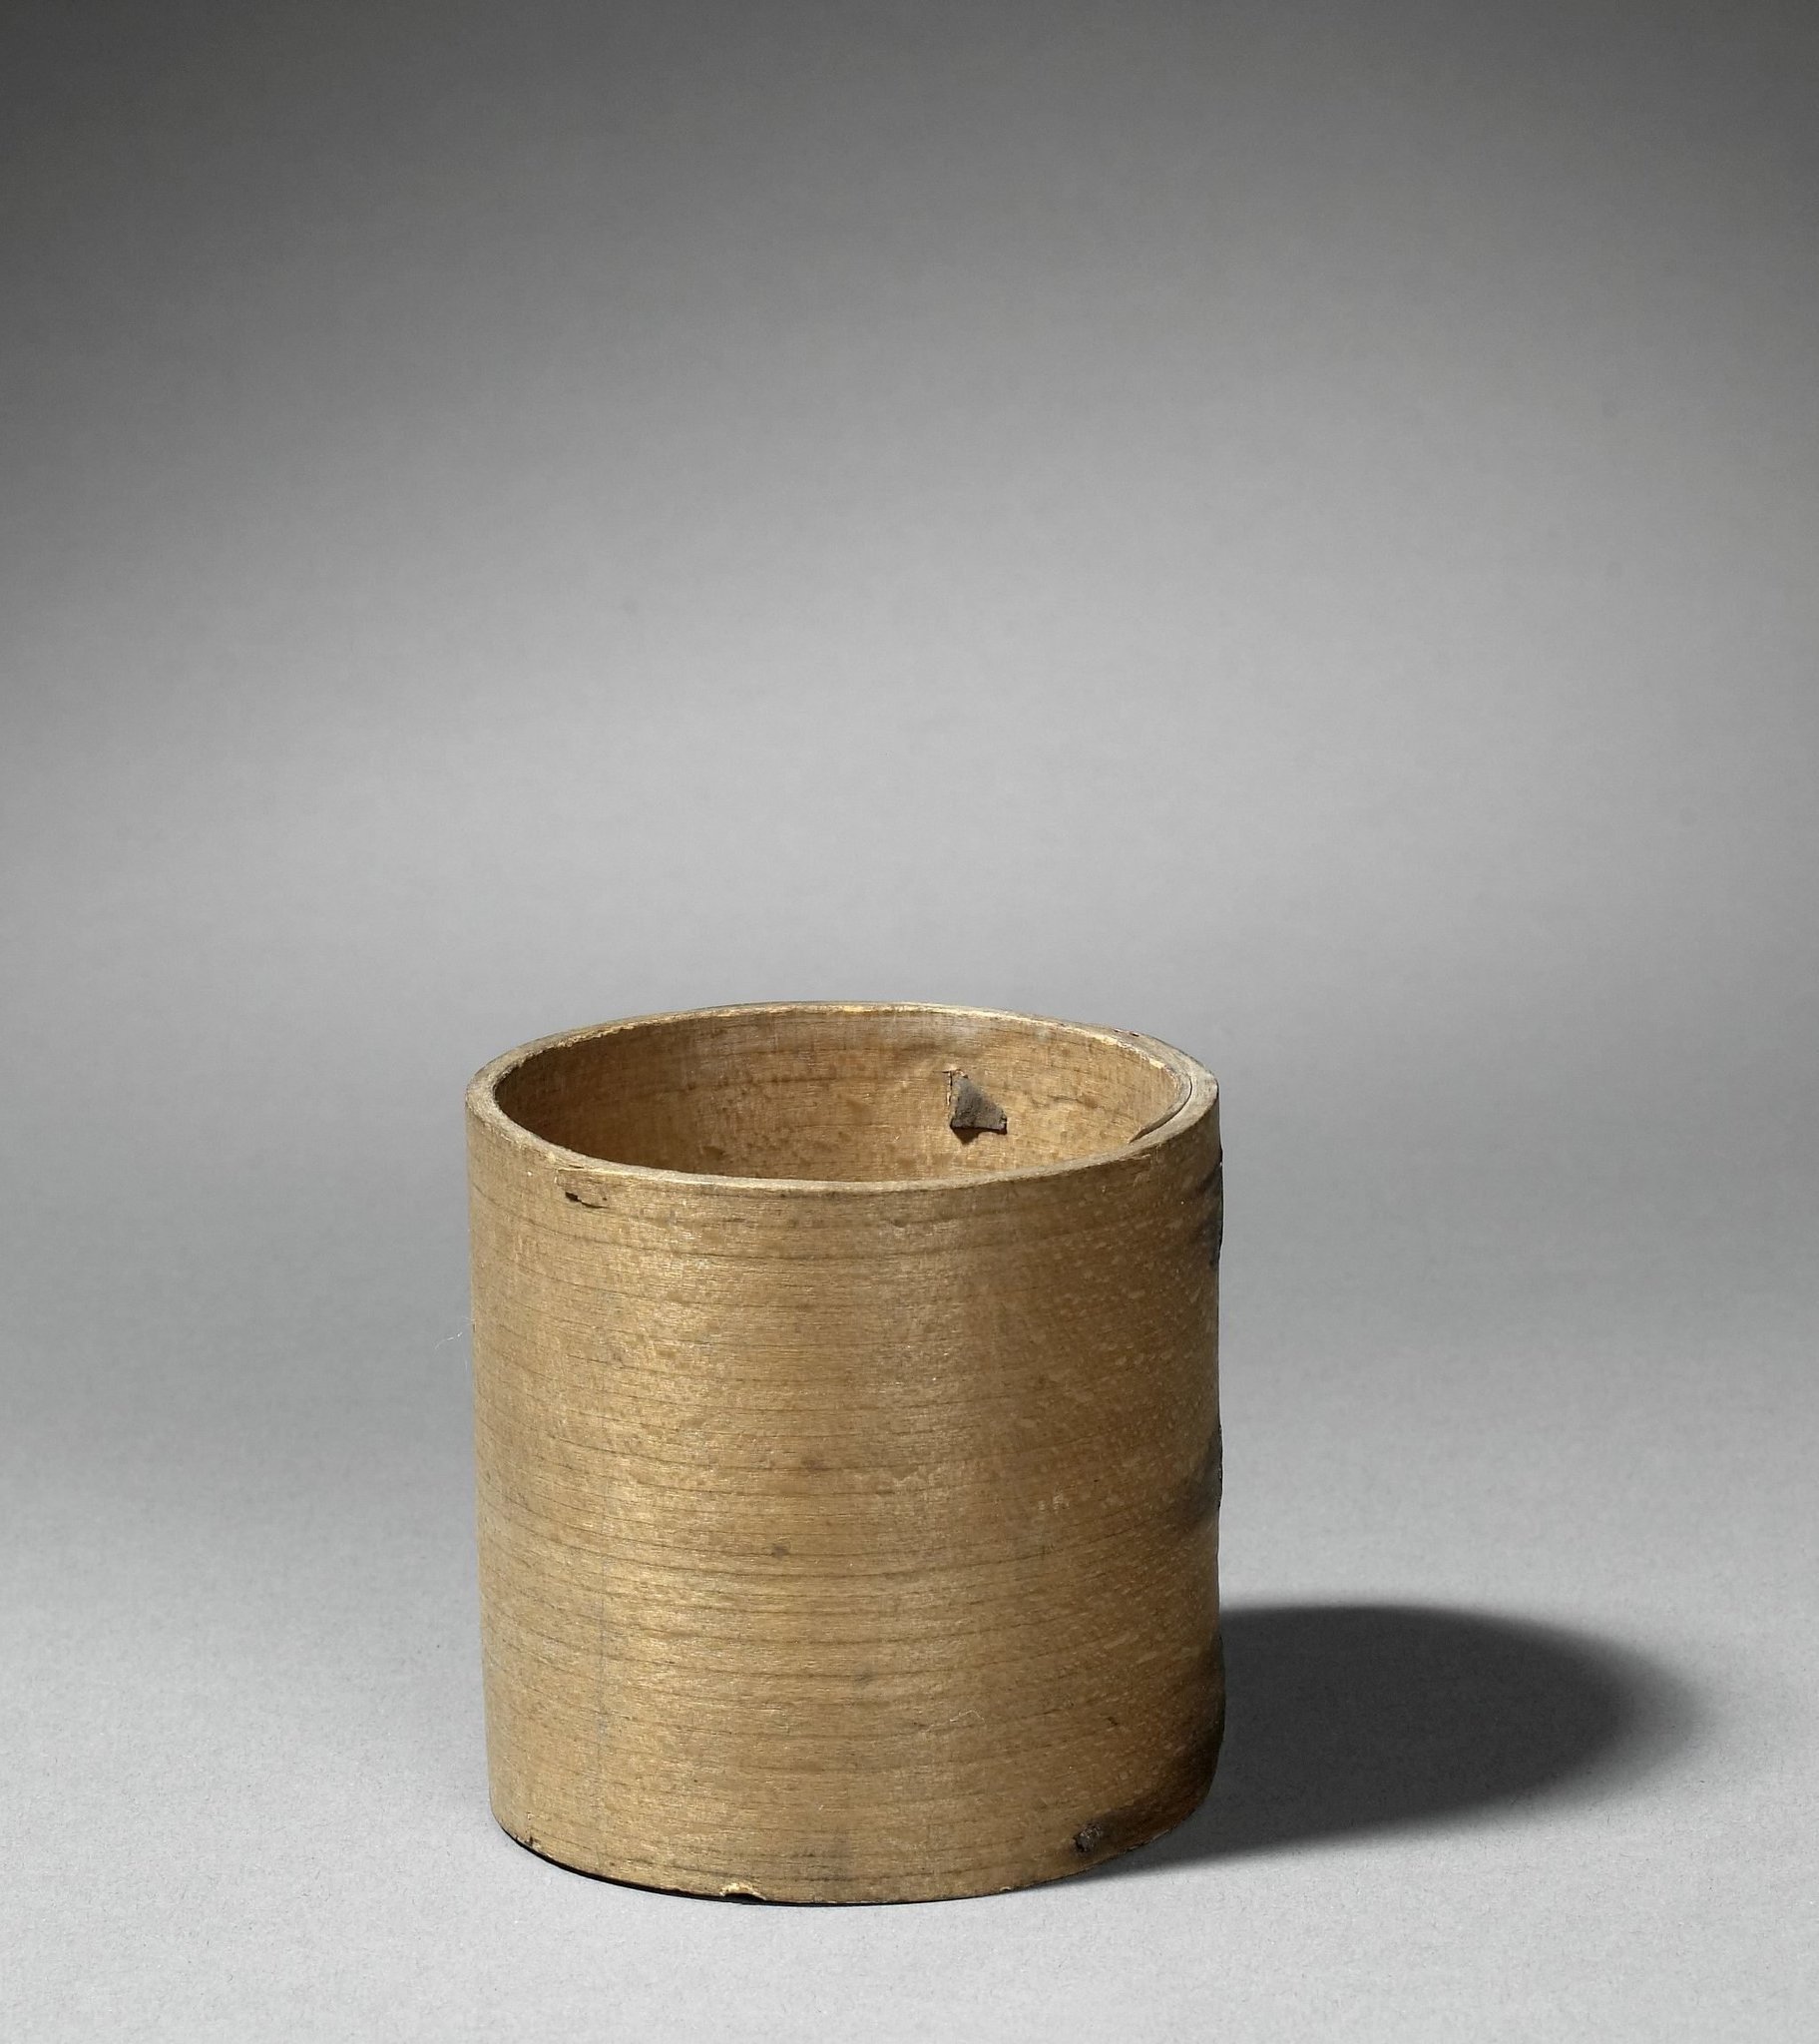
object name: inhoudsmaat droge waren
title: Inhoudsmaat van 2 dl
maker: Anonymous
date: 1820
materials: wood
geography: netherlands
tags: netherlands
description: Spanen inhoudsmaat van 2 dl. Geen opschriften of merken.